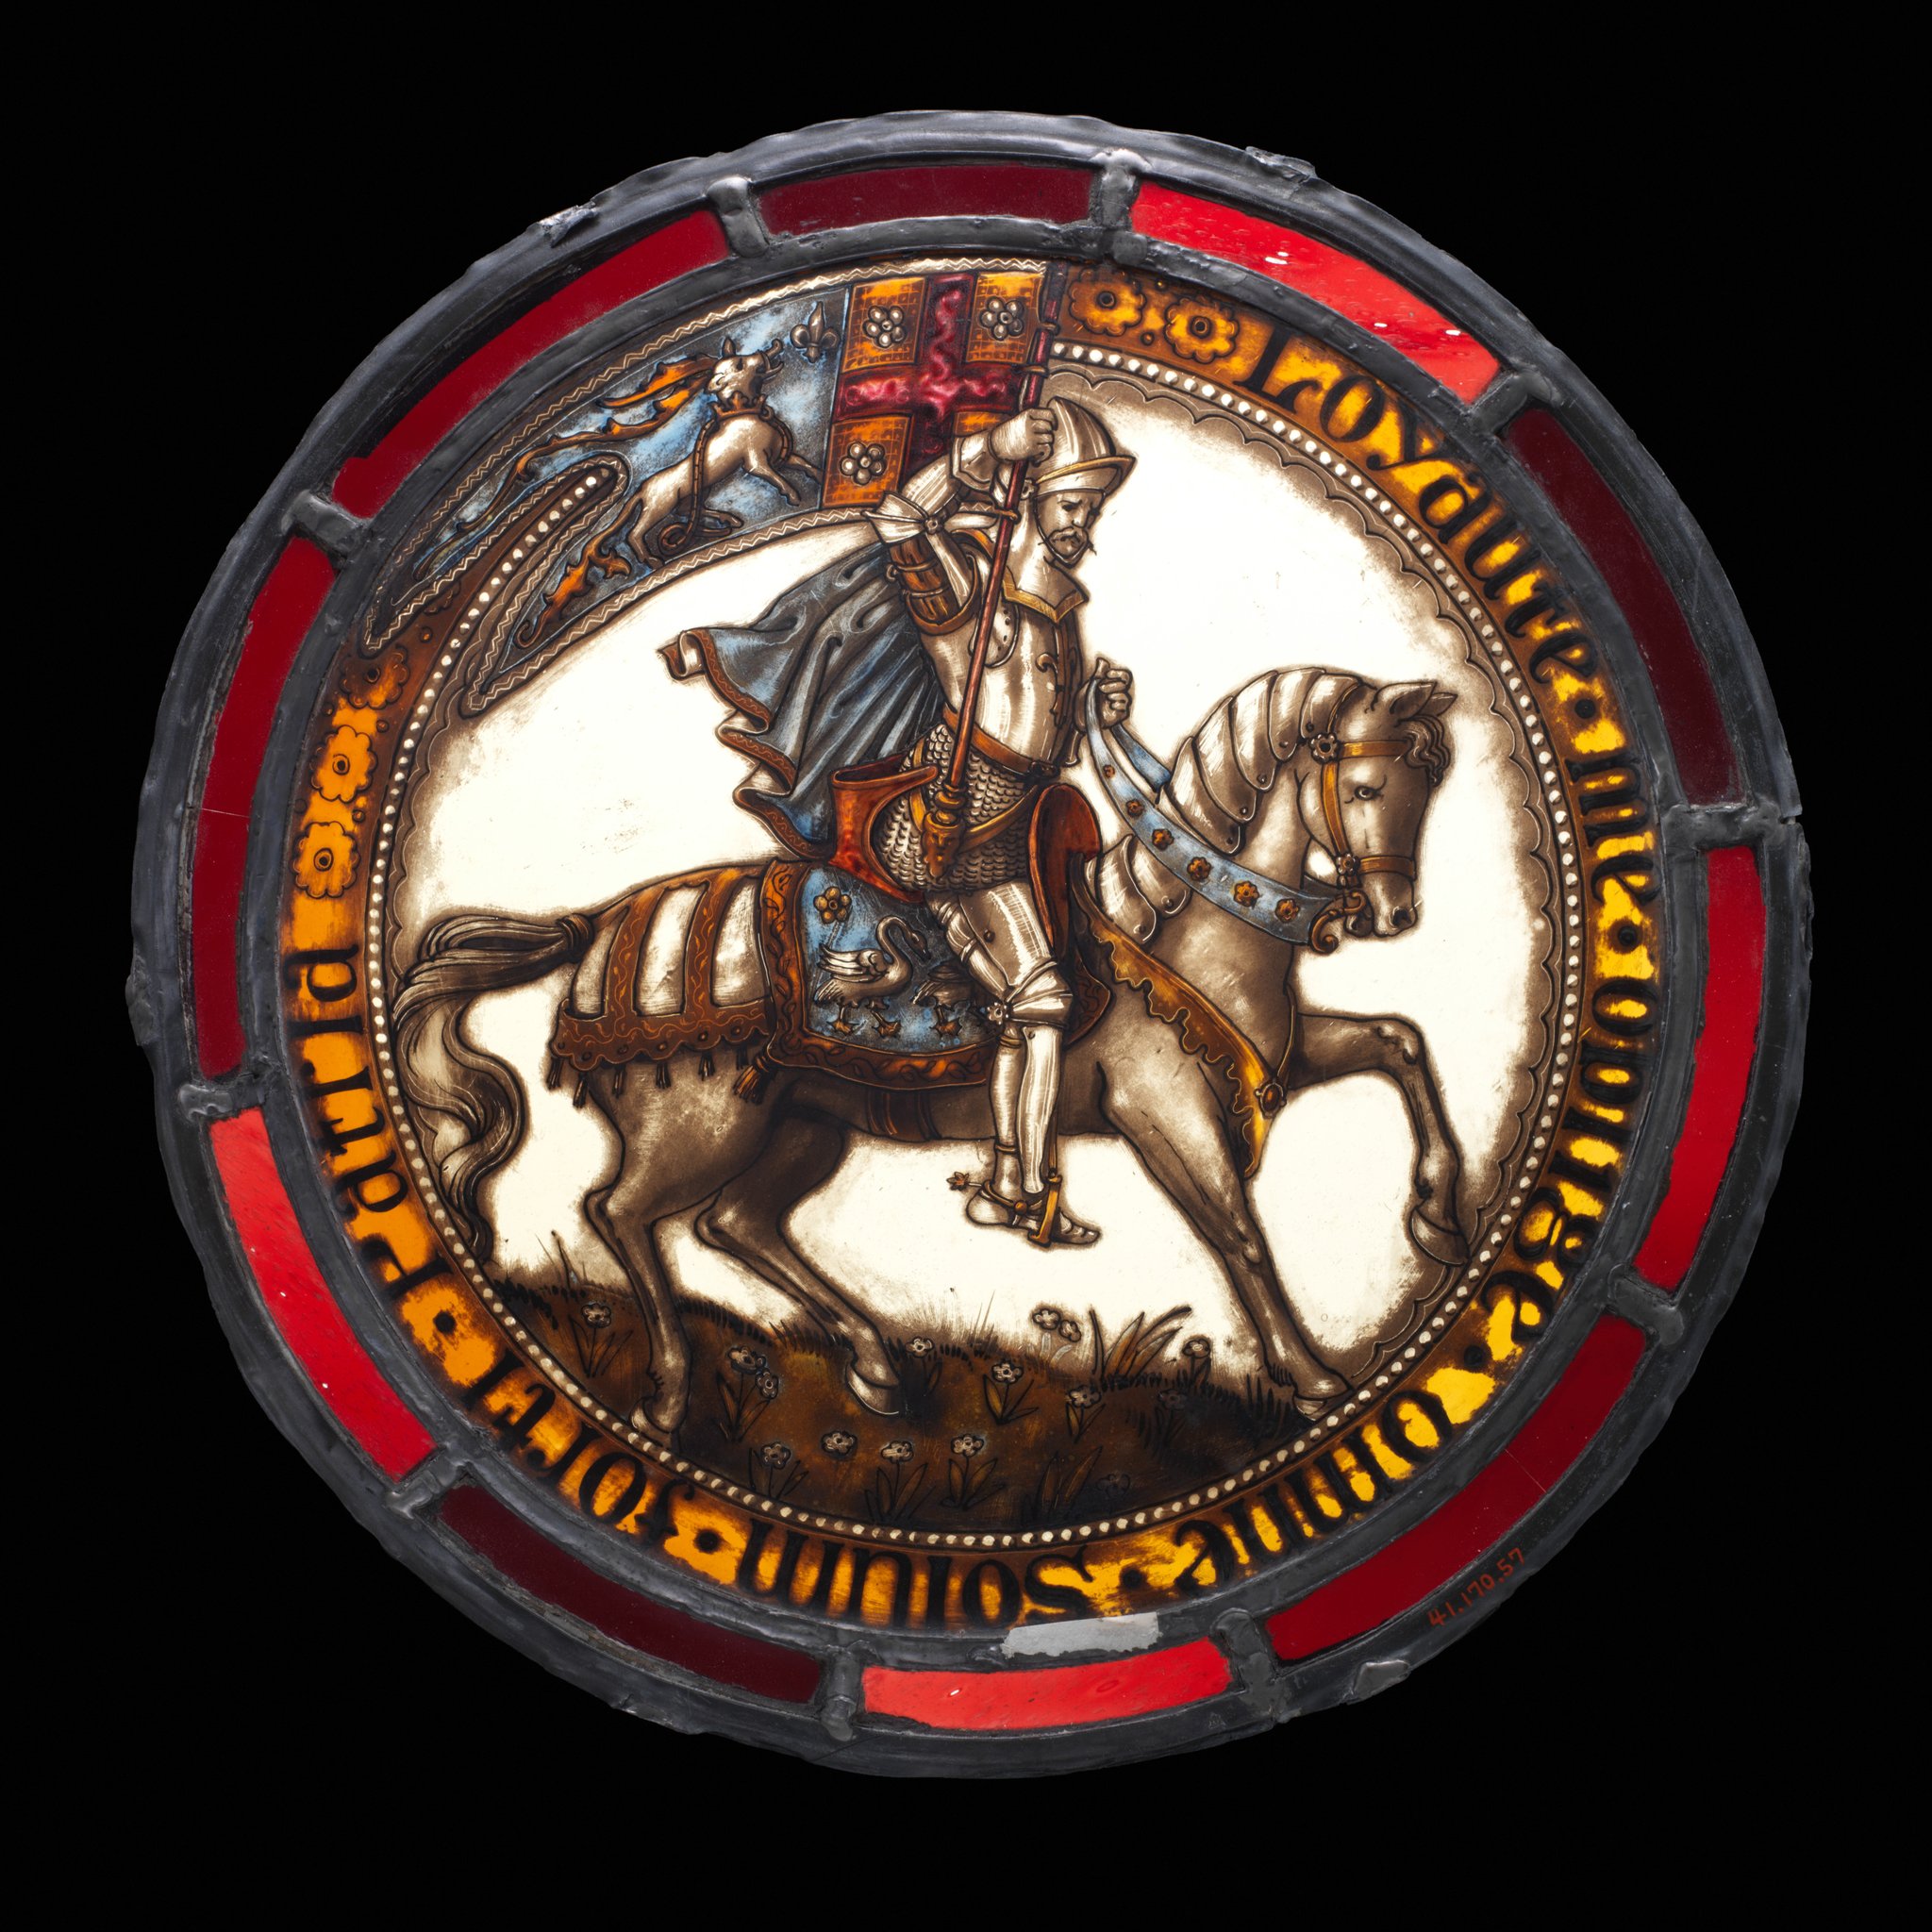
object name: medallion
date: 1801-1850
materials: glass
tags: armor,horses,flags,knights